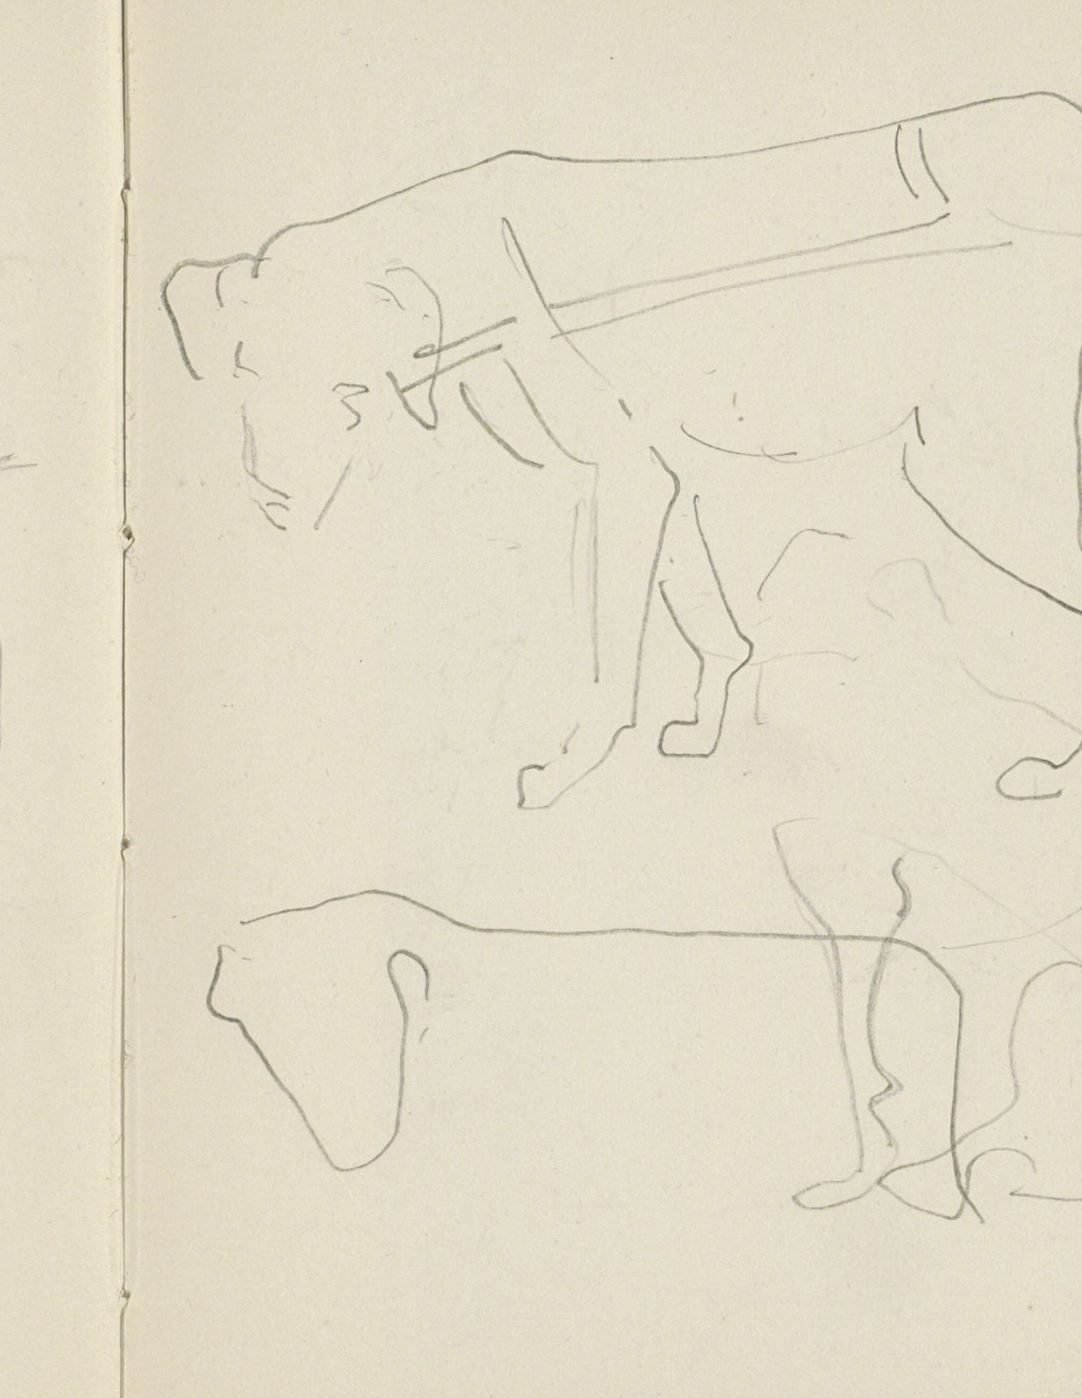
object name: sketchbook leaf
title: Honden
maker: reijer stolk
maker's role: draughtsman, print maker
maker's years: 1896-1945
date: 1906-1945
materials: paper, pencil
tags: dog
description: Blad 37 recto uit een schetsboek met 69 bladen.